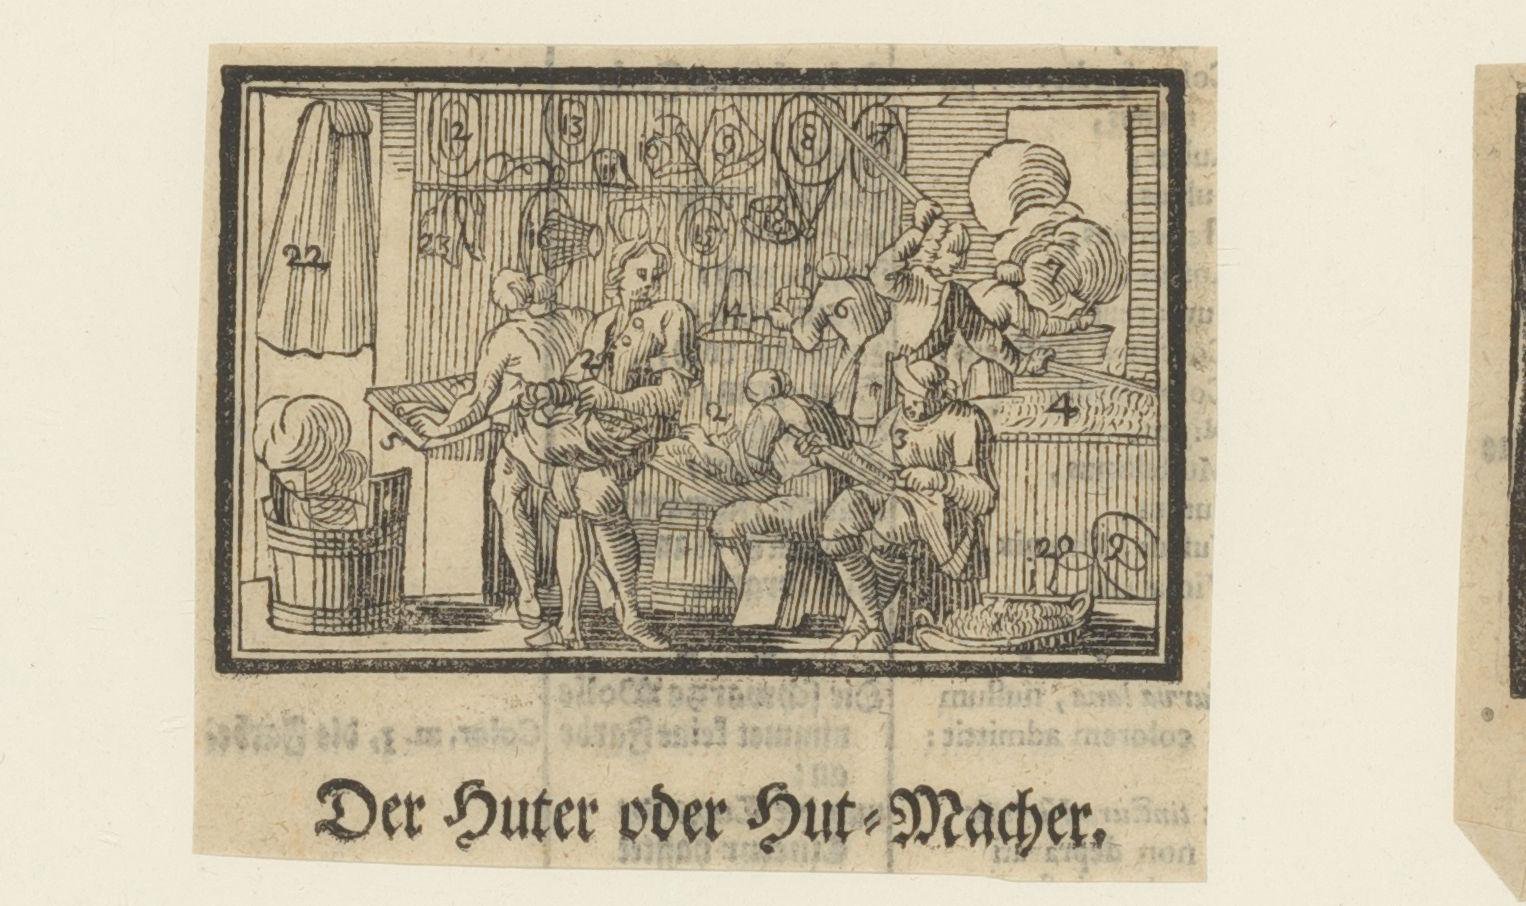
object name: book illustration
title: Hoedenmaker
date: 1719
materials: paper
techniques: letterpress printing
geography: nuremberg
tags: handicrafts, craftsman at work, hatter, textile fabric, cloth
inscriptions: stamp, collector's mark: Lugt 1641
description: Prent uit: Comenius, Johannes Amosius. Orbis sensualium picti pars prima (...). Neurenberg: Martin Endter, 1719, dl. 2, p. 172. Prent eerder gebruikt in: Comenius, Johannes Amosius. Orbis Sensualium Picti denuo aucti Pars Secunda (...). Neurenberg: Martin Endter, 1730, dl. 2.